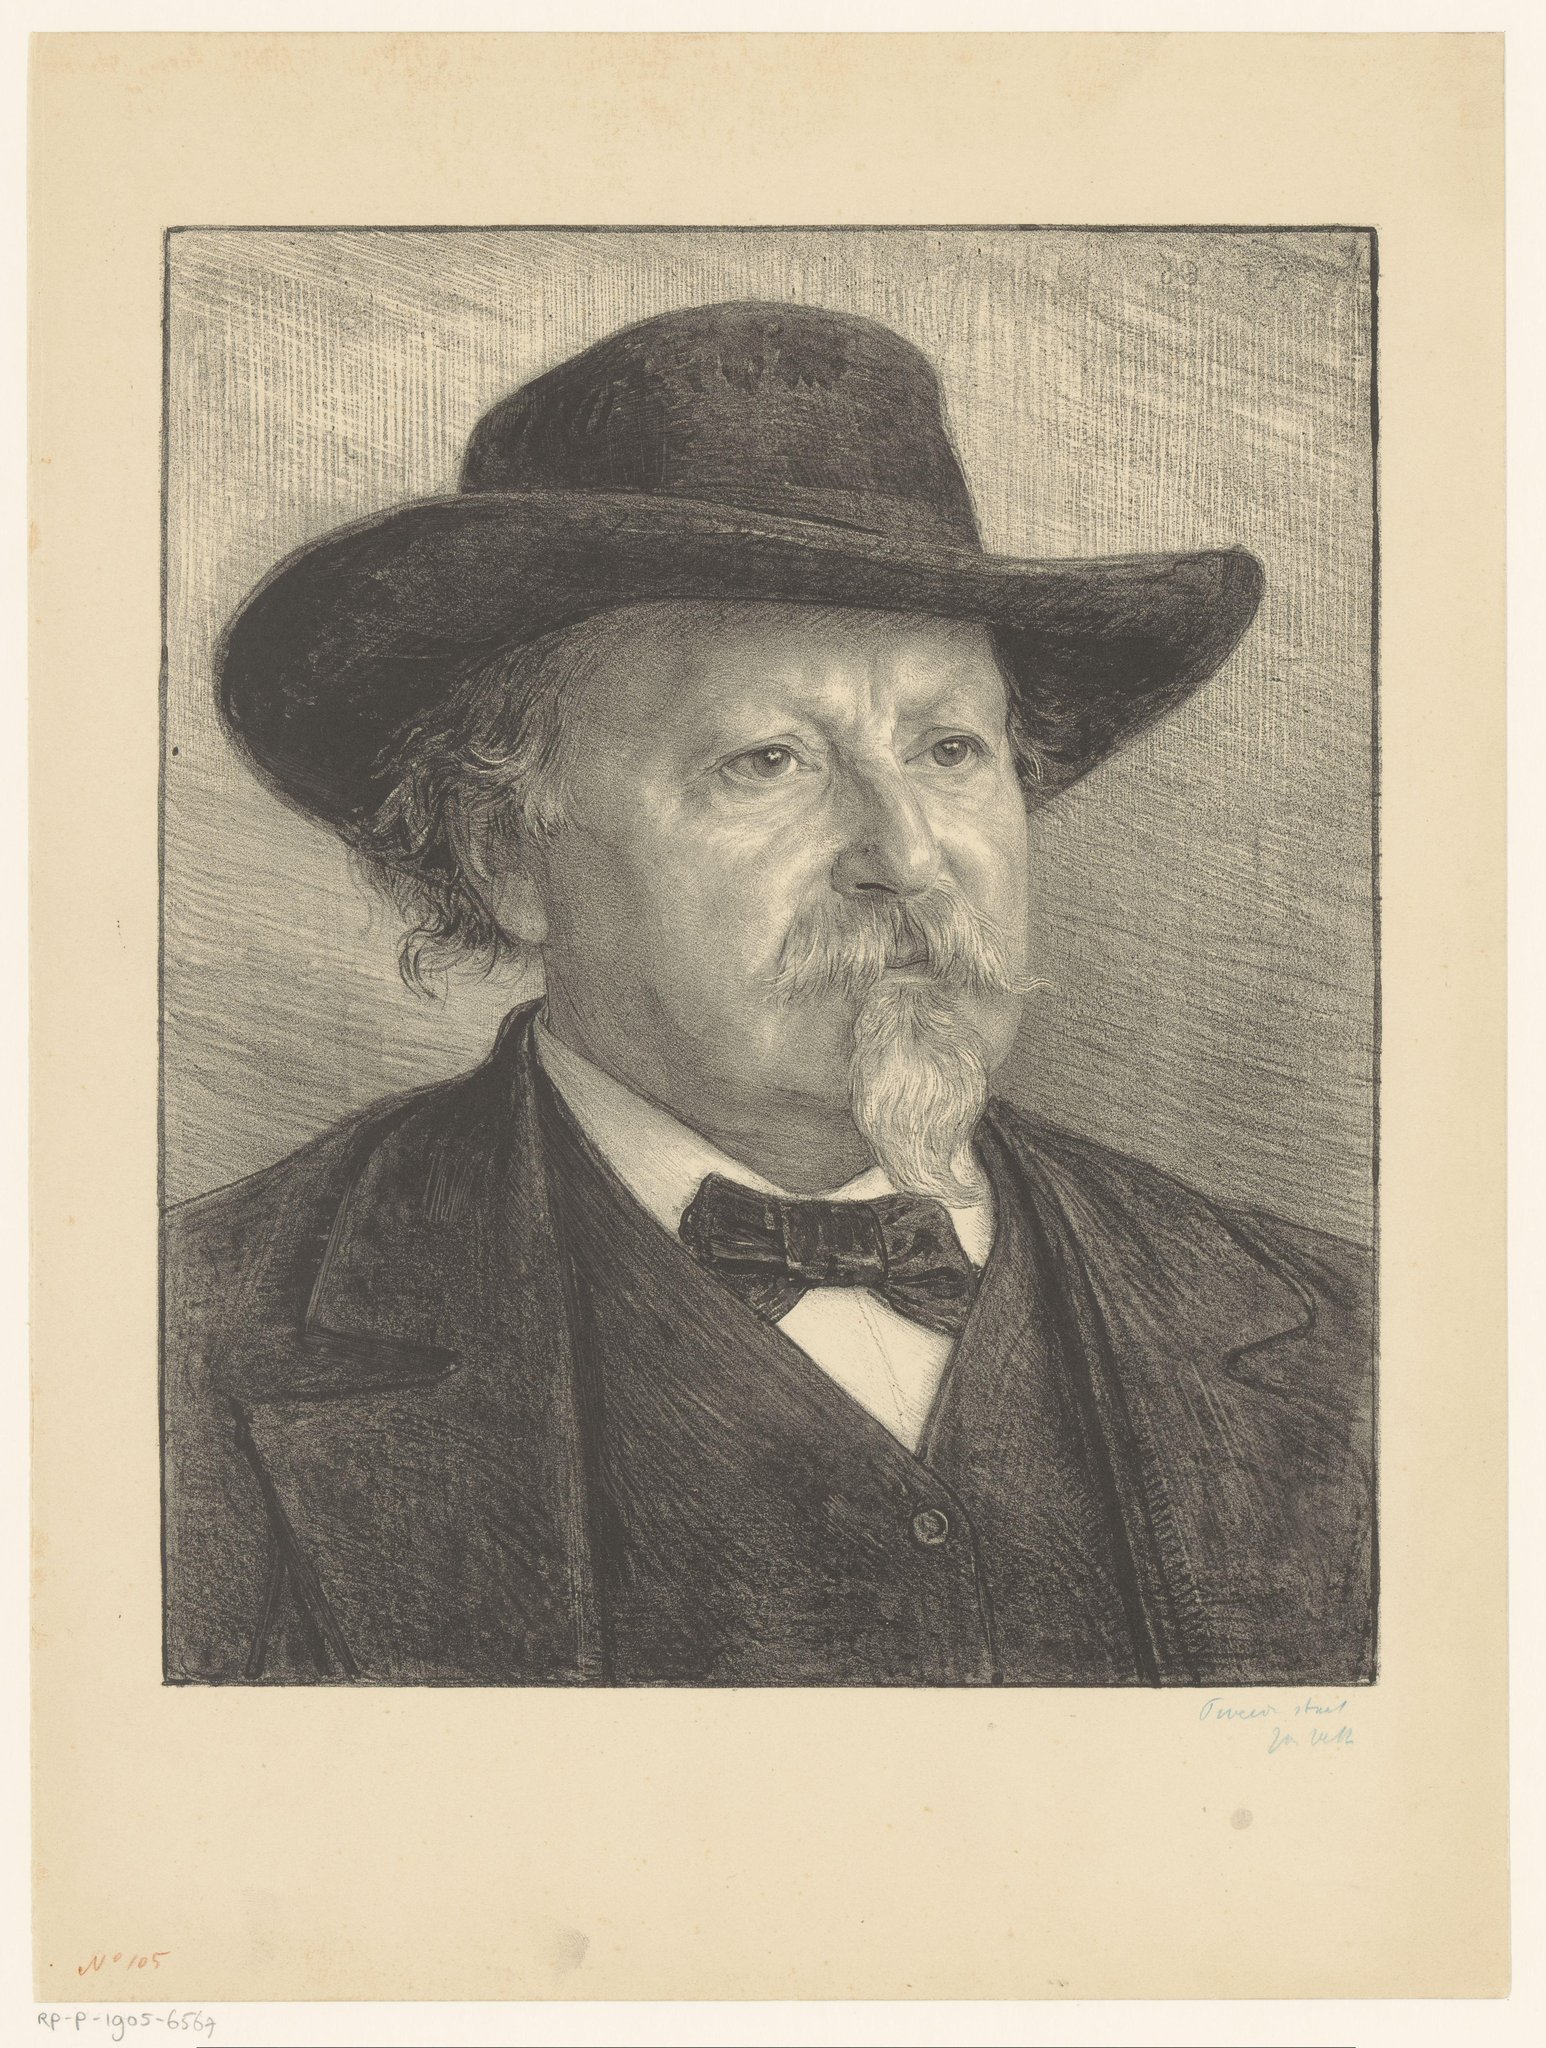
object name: print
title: Portret van Johan Philip van der Kellen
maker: jan veth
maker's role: designer, draughtsman, painter, print maker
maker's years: 1864-1925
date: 1897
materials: paper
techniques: lithograph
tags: utrecht, print maker, draughtsman, johan philip van der kellen, historical persons (+ (full) bust portrait)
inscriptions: inscription: ‘Tweede staat / Jan Veth’, collector's mark: Lugt 2228